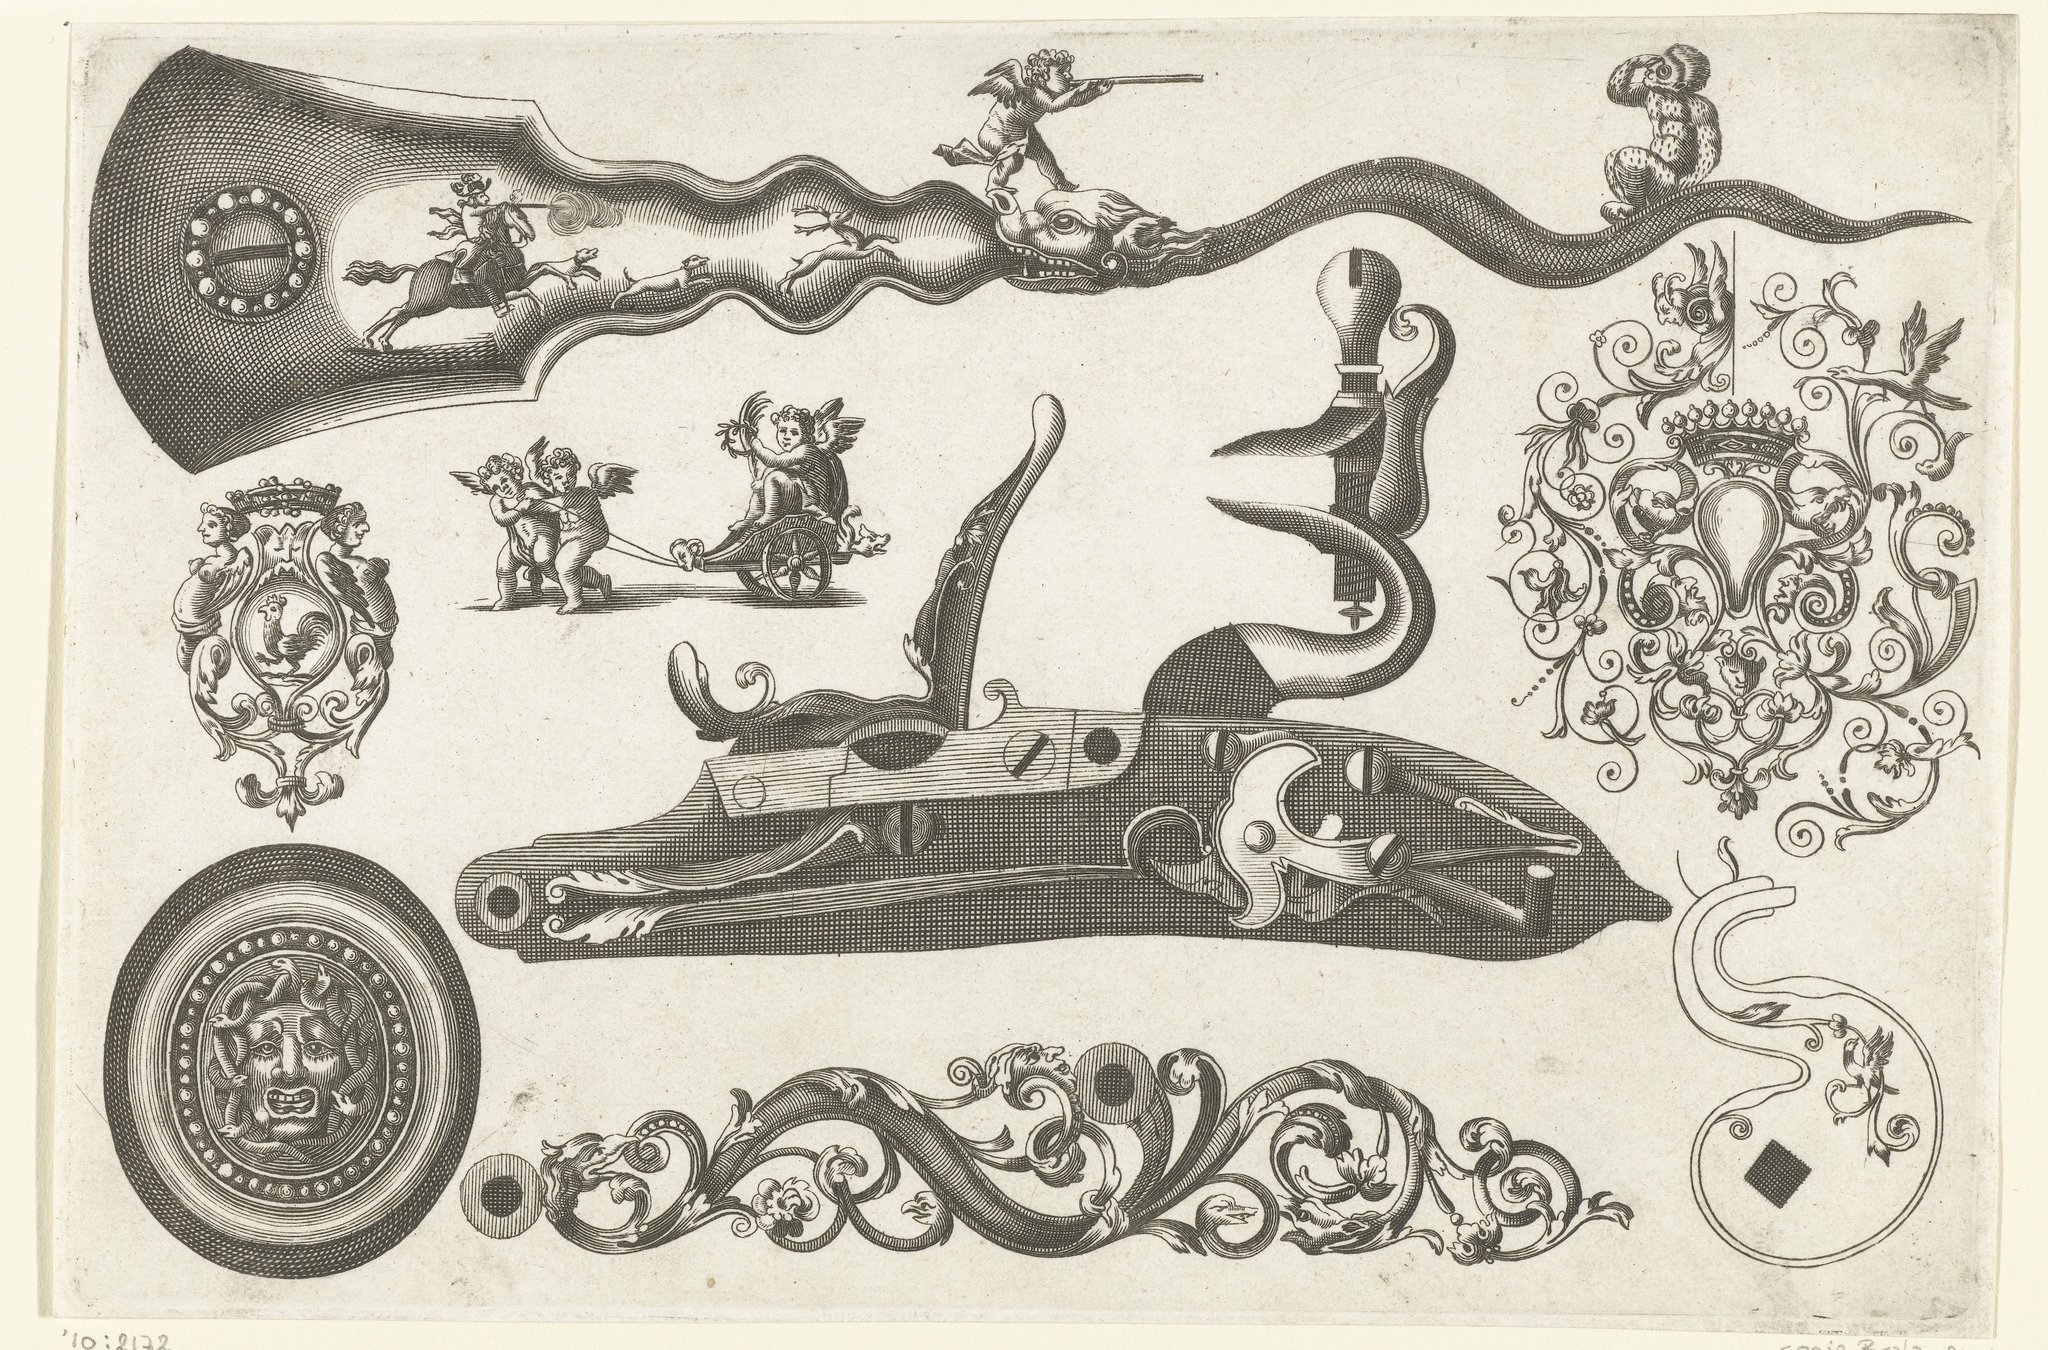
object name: print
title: Acht affuiten en ornamenten voor geweren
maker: pieter schenk (i)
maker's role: print maker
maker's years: 1660-1711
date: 1692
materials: paper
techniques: engraving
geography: amsterdam